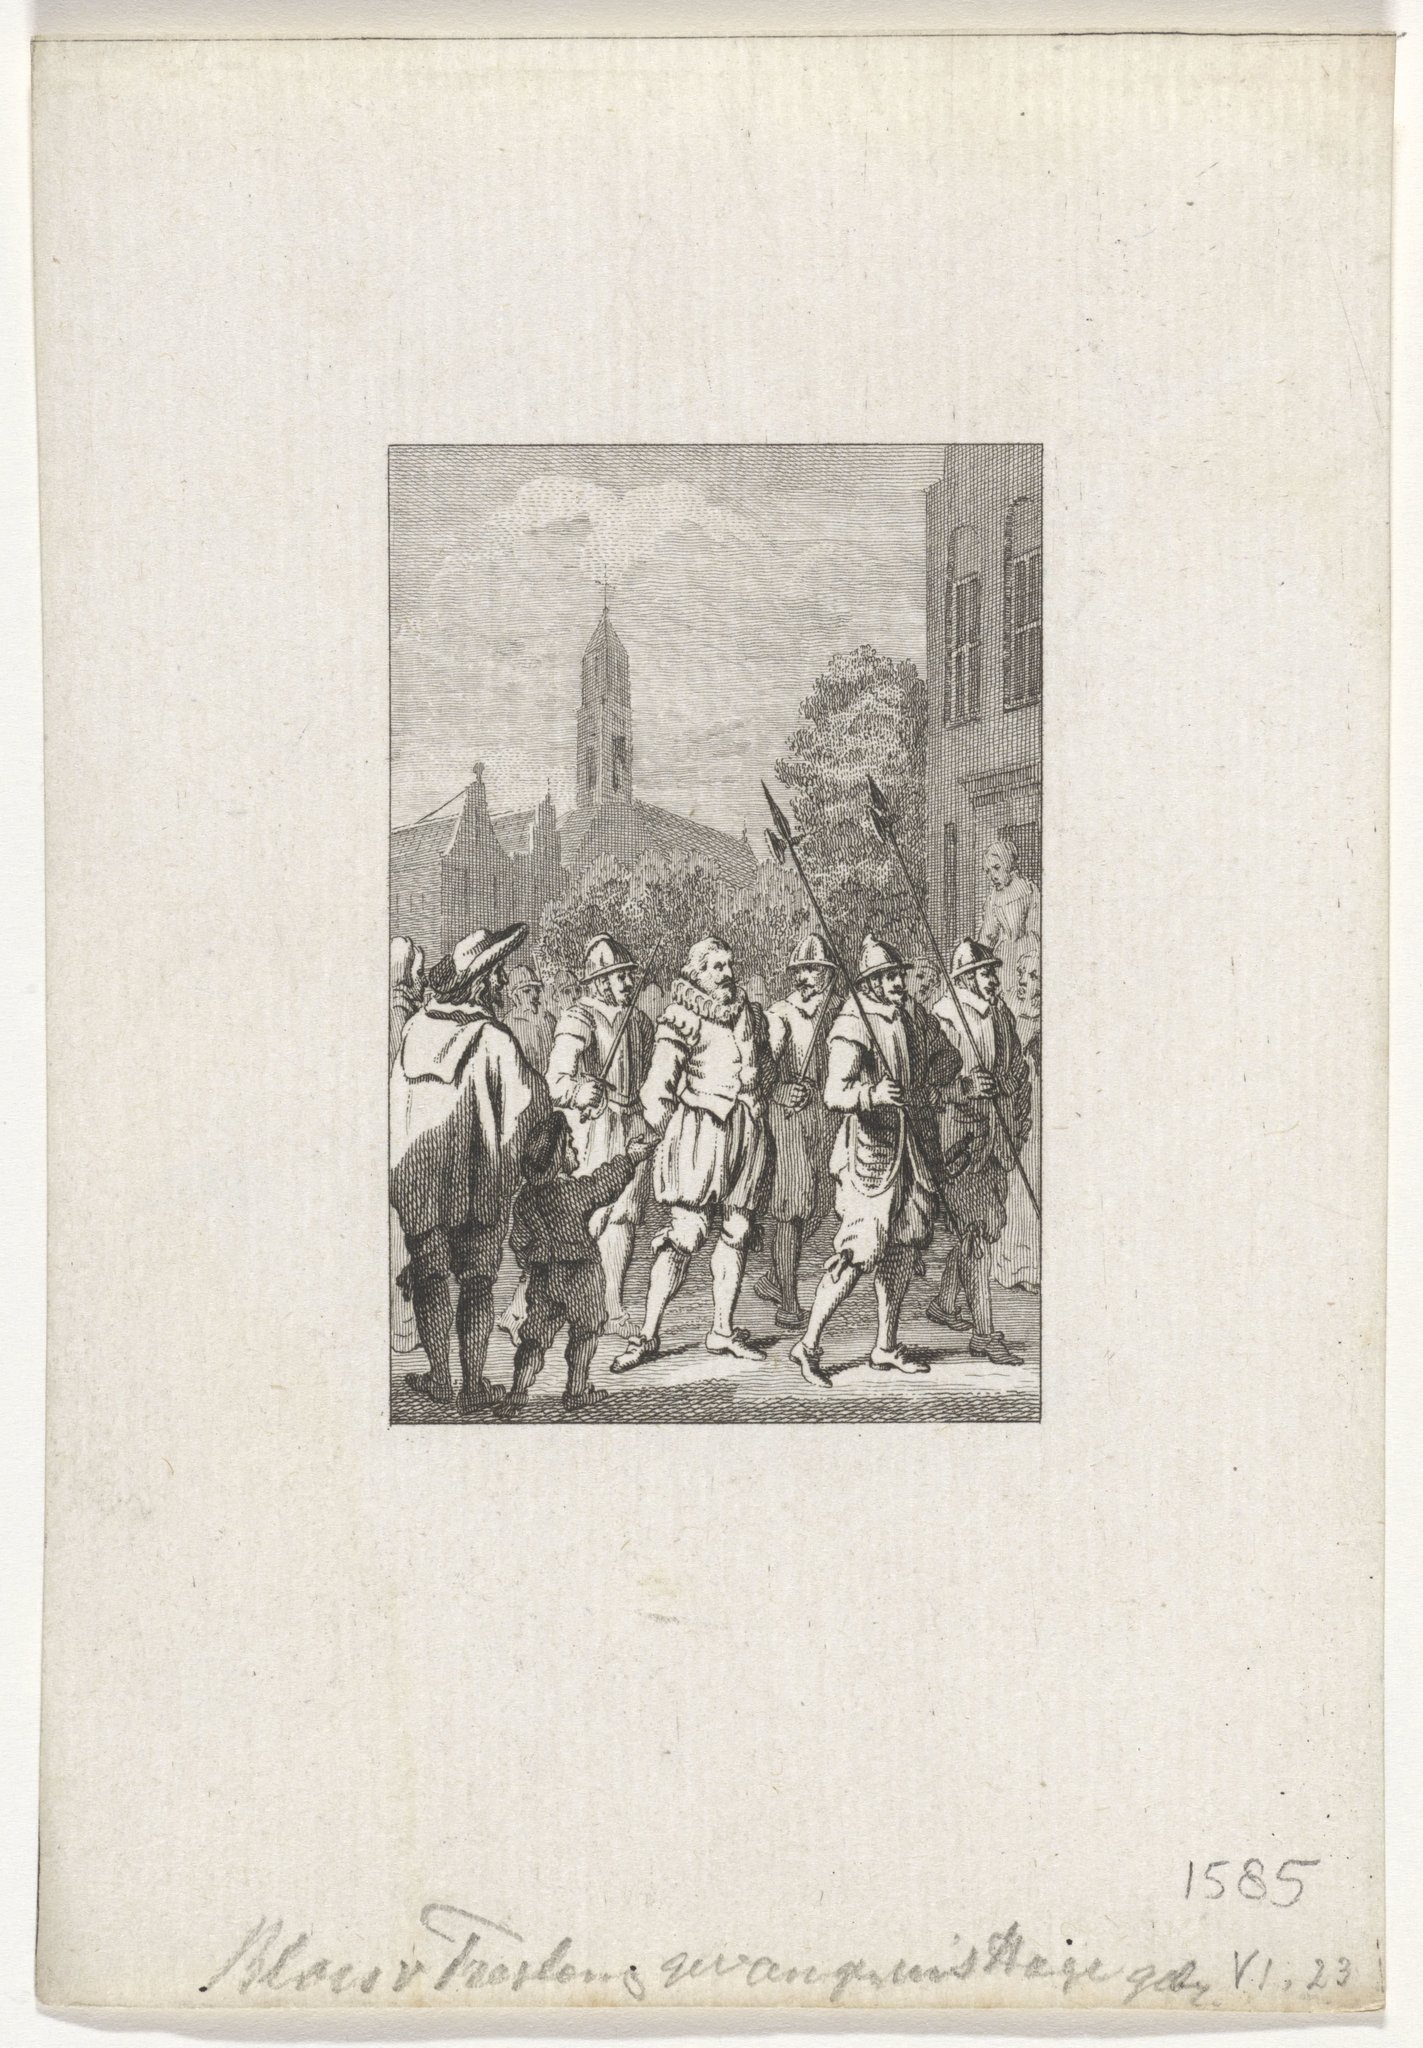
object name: print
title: Admiraal Blois van Treslong gevangen genomen en naar het Gravensteen te Middelburg gebracht, 1585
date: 1783-1795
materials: paper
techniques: etching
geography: amsterdam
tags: imprisonment, middelburg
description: Admiraal Blois van Treslong, beticht van corruptie en insubordinatie, wordt gevangen genomen en onder militaire escorte naar het Gravensteen te Middelburg gebracht, 27 februari 1585.